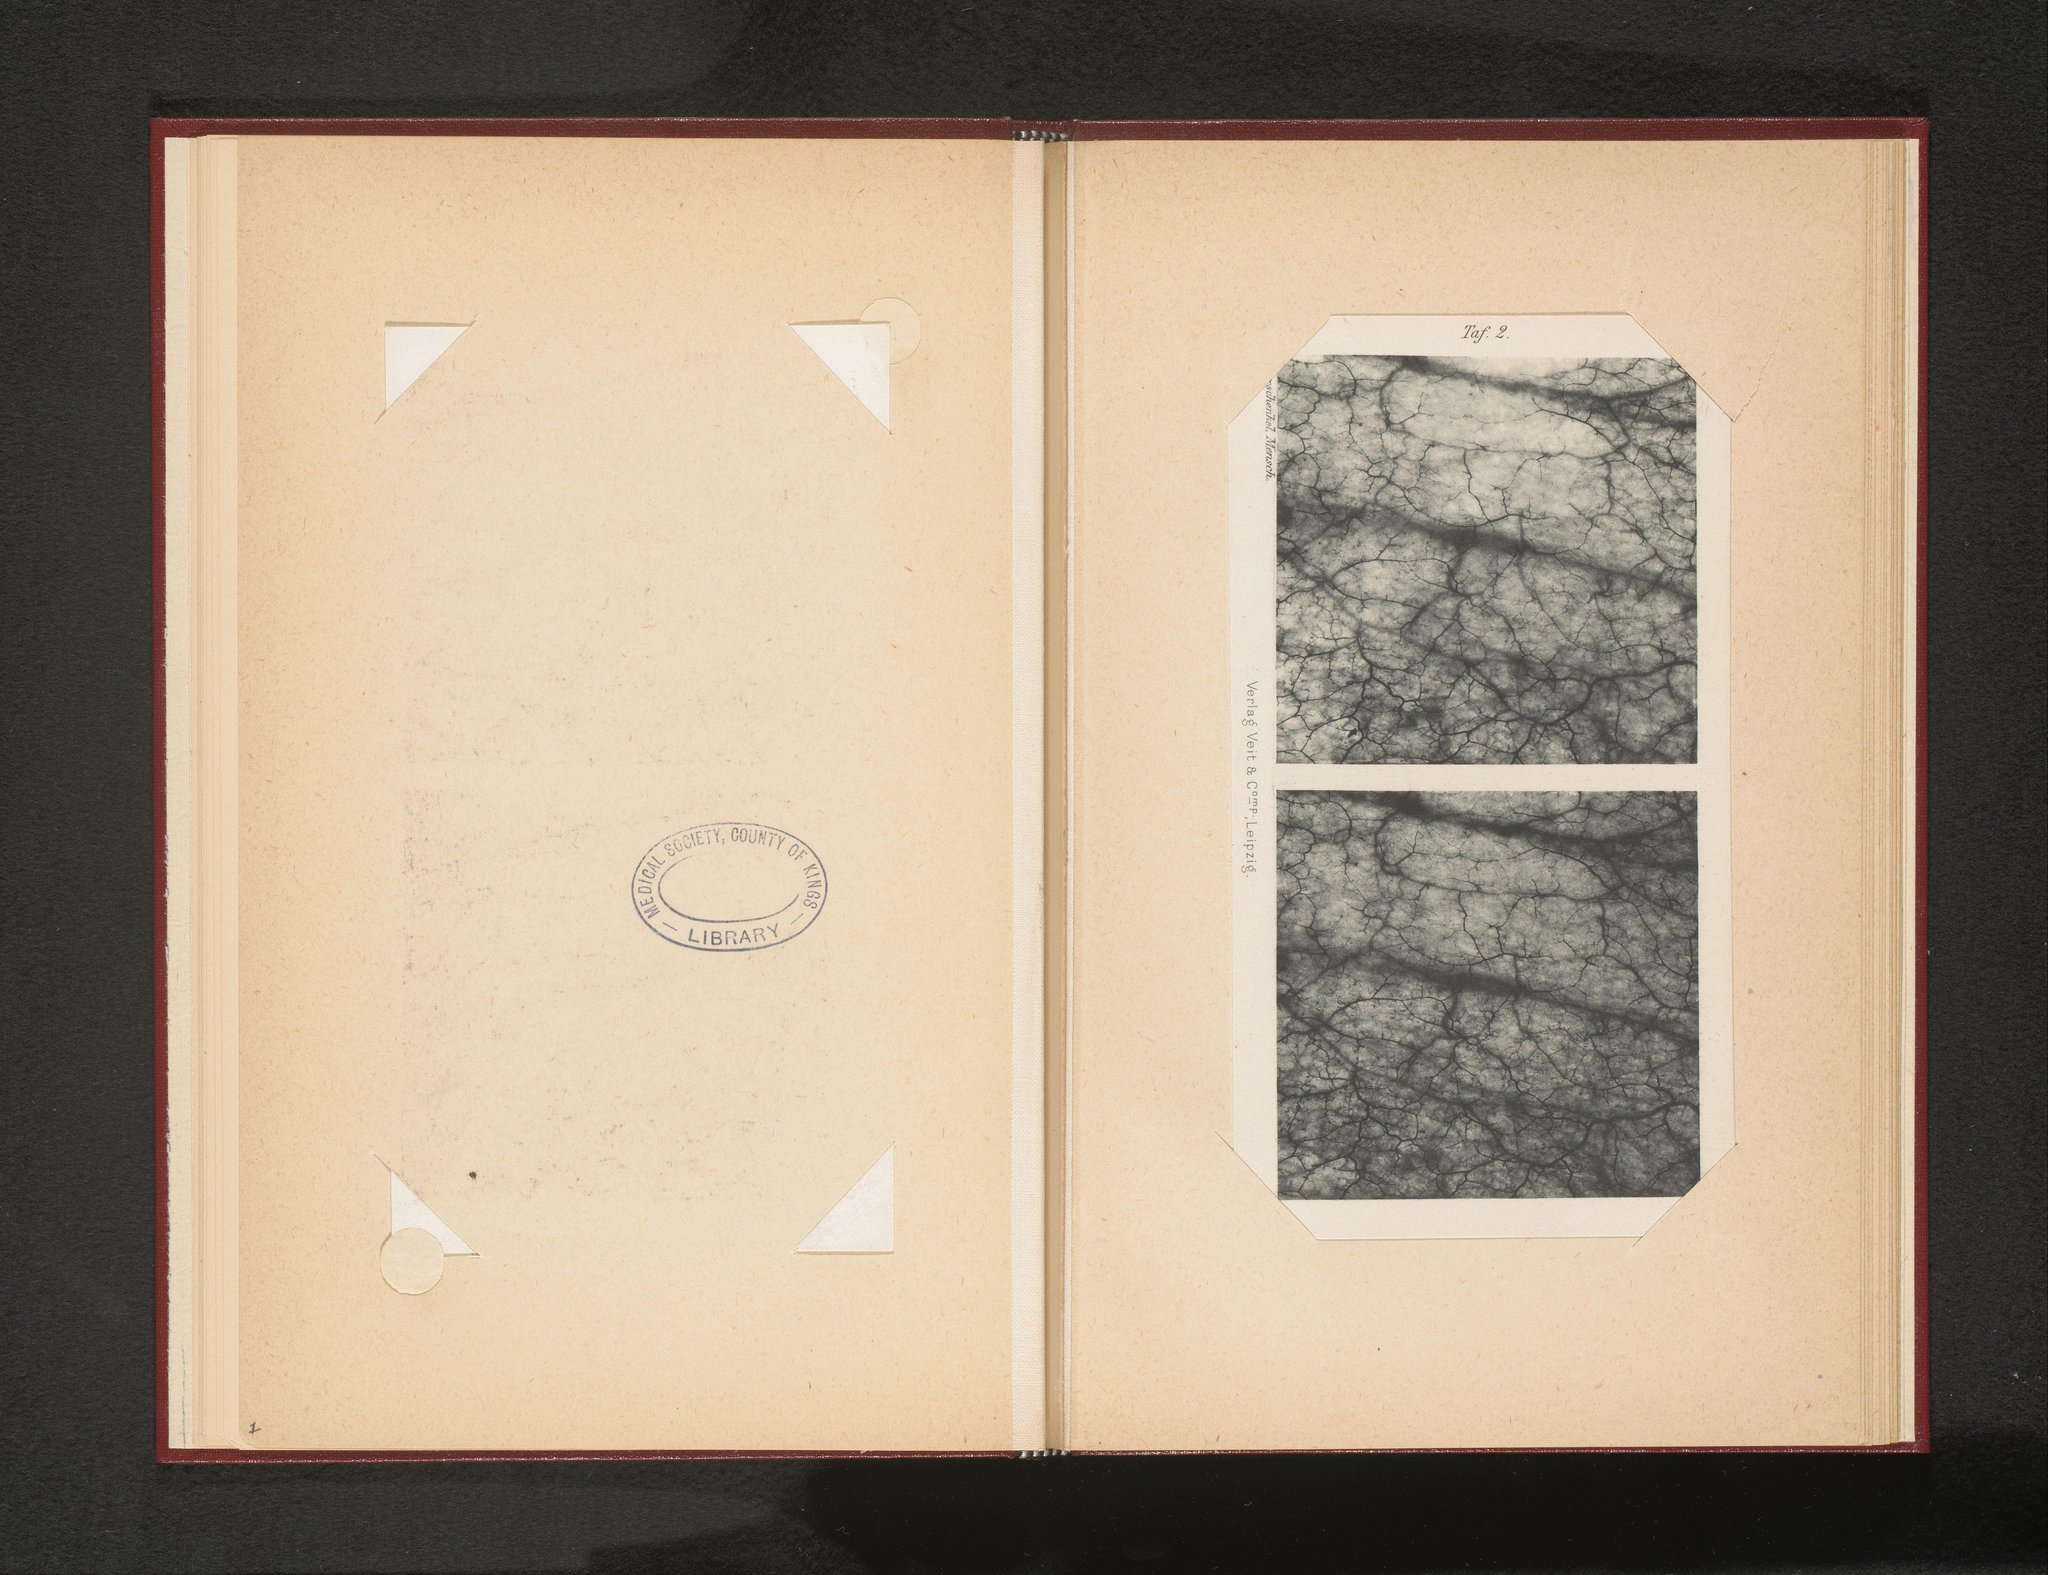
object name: stereograph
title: Microscoopopname van menselijke huid van een onderbeen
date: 1885-1895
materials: paper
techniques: photoaquatint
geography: leipzig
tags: skin (human)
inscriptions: number: ‘Taf. 2.’